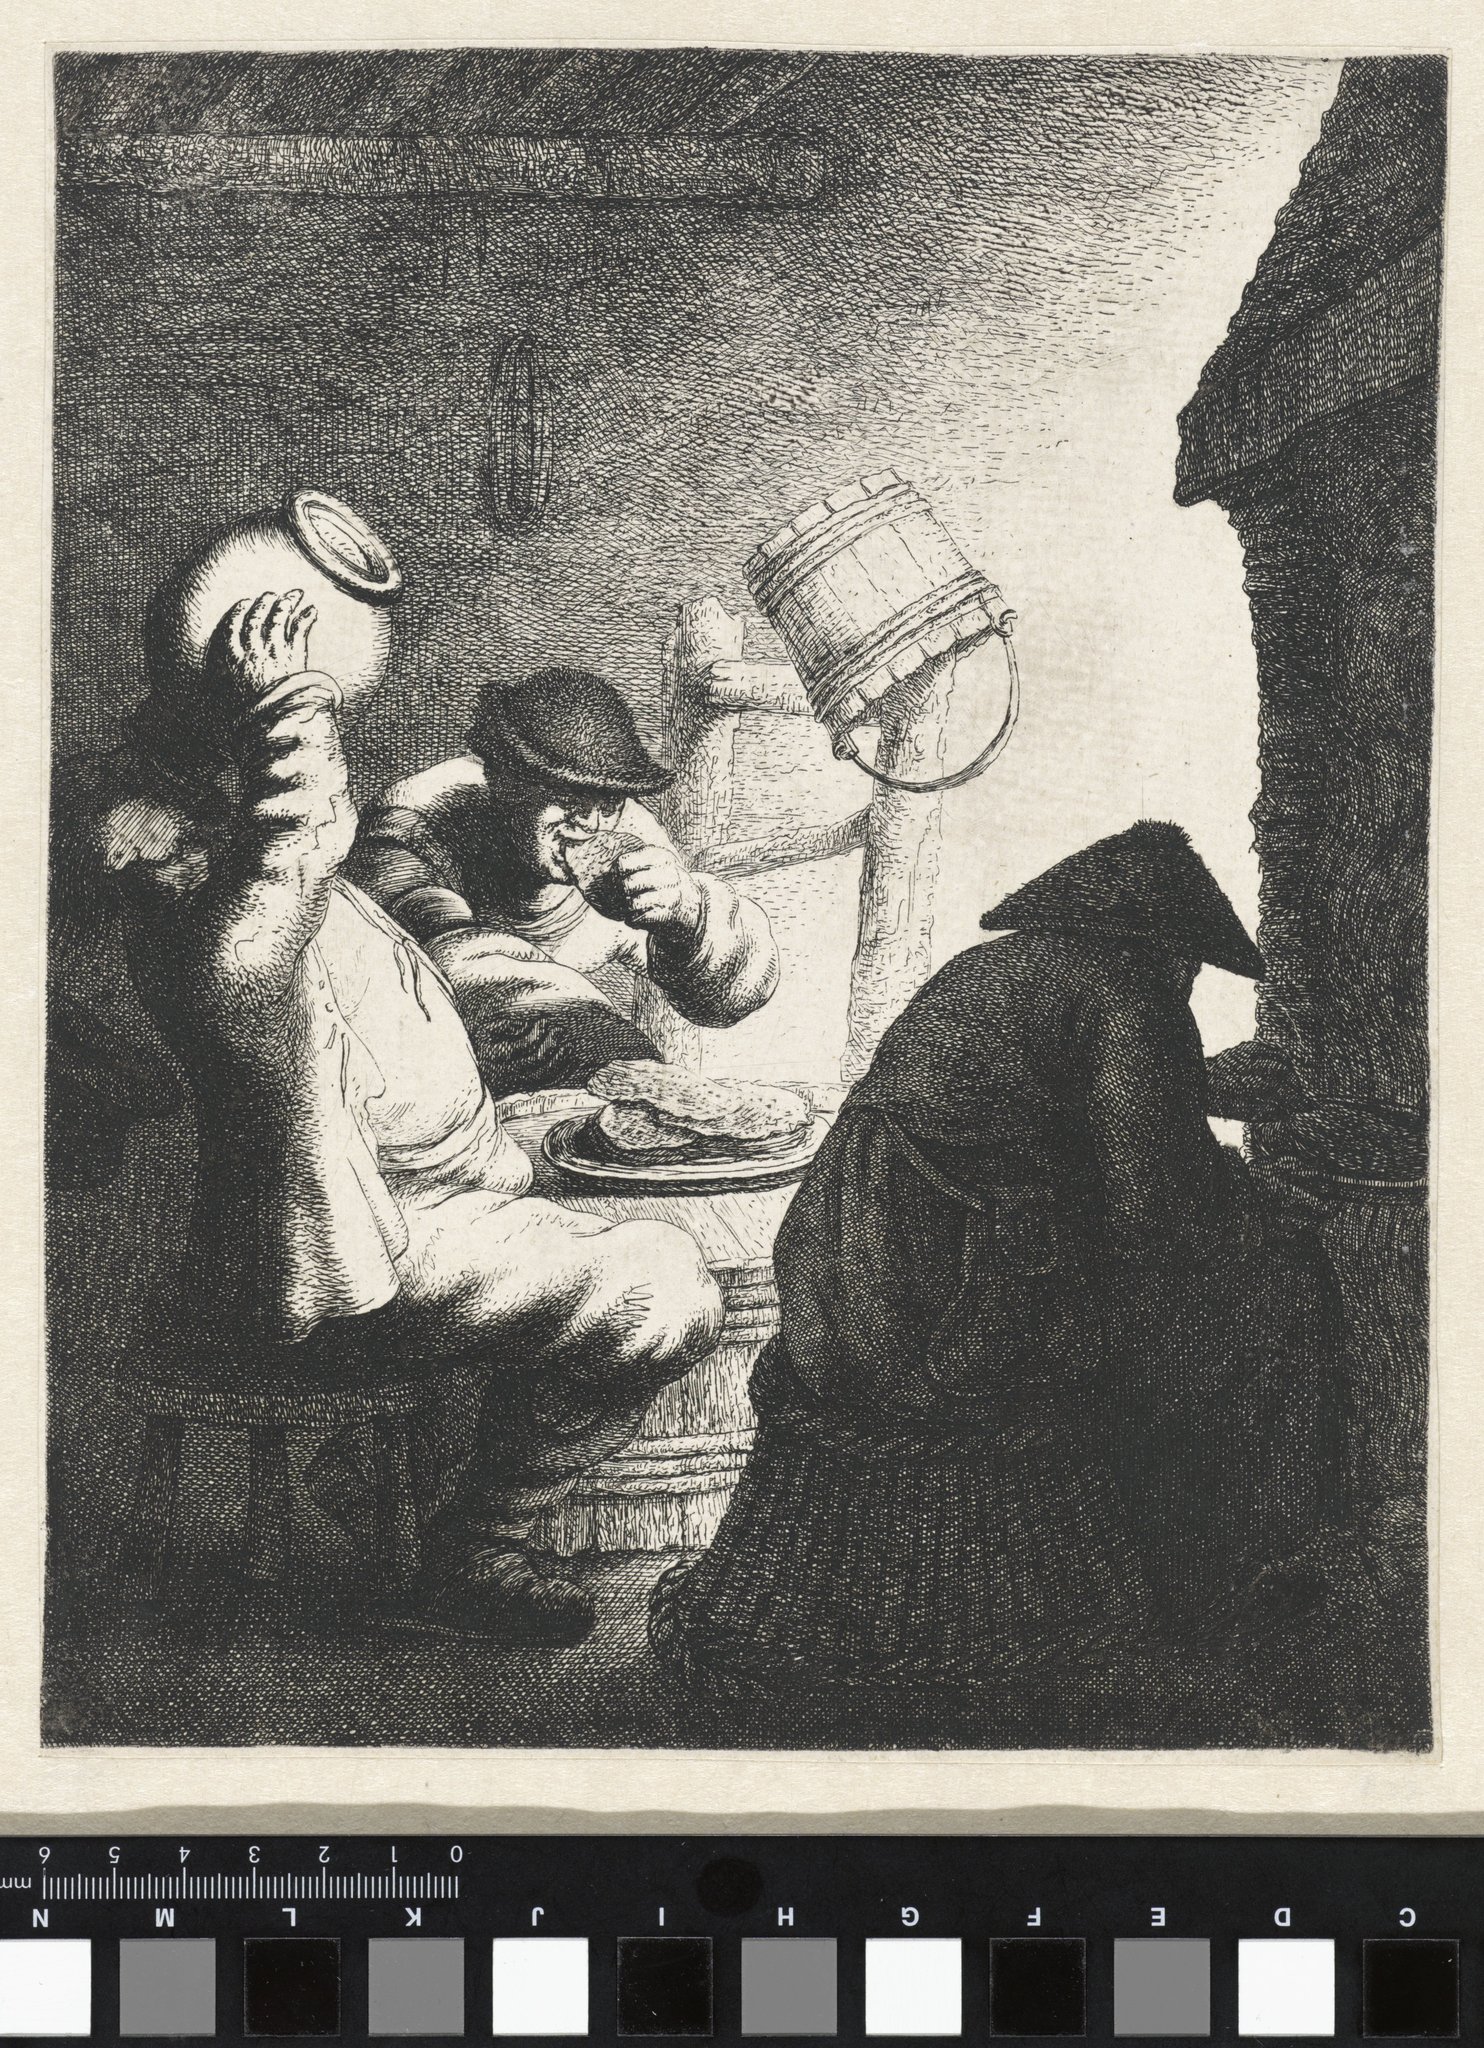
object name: print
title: Figuren eten pannenkoeken in een interieur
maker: jan gillisz. van vliet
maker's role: draughtsman, painter, print maker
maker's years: 1600-1668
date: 1634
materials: paper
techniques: engraving, etching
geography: leiden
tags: pancakes, wooden container: barrel, cask, bucket, taste, tasting (one of the five senses), jar, jug (used as drinking-vessel)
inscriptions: collector's mark: Lugt 2228, collector's mark: ‘F.D. 1839’ 985, inscription: ‘de Cl no. 27’ Lugt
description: In een boereninterieur bakt een vrouw pannenkoeken op een vuur. Aan een ronde tafel zit een man die pannenkoeken eet en een man die uit een kruik drinkt. Op een hek een omgekeerde emmer.